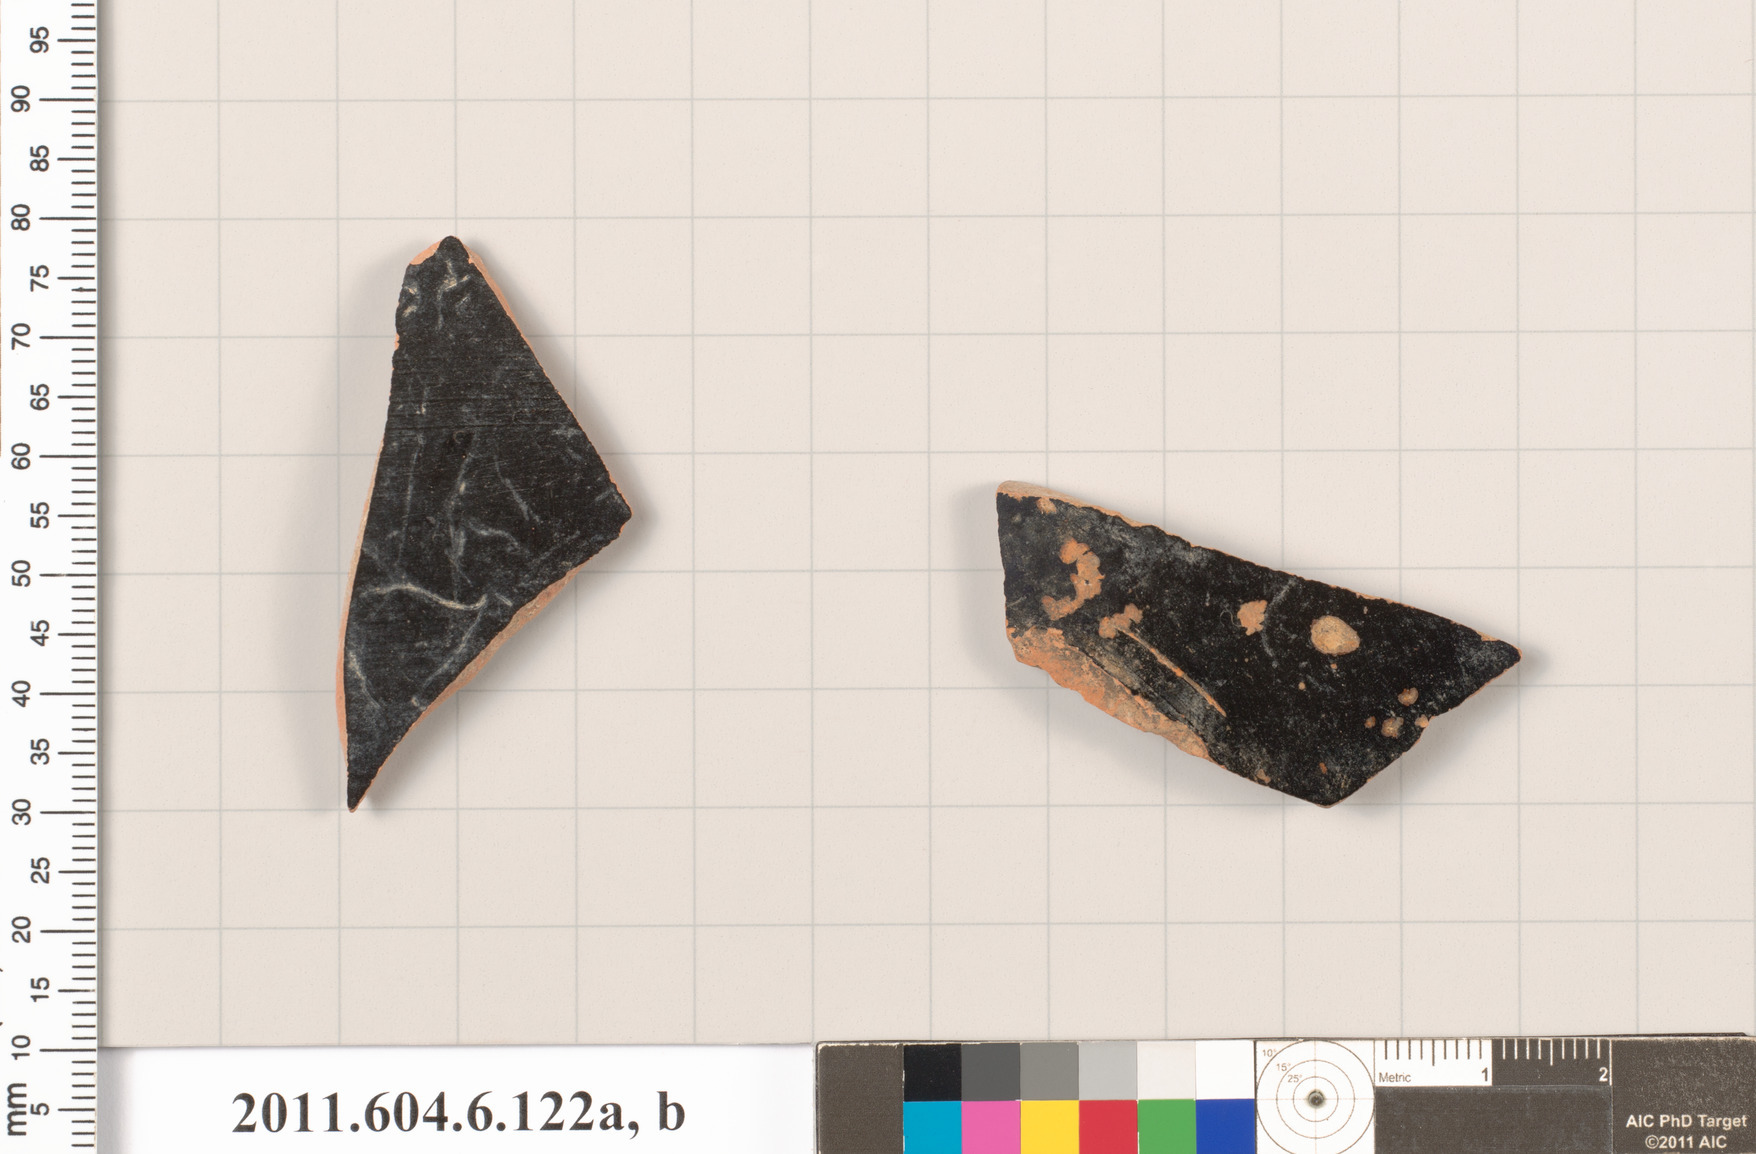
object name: undetermined closed shape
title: Terracotta fragments of closed shapes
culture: greek, attic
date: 600-401 BCE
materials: terracotta